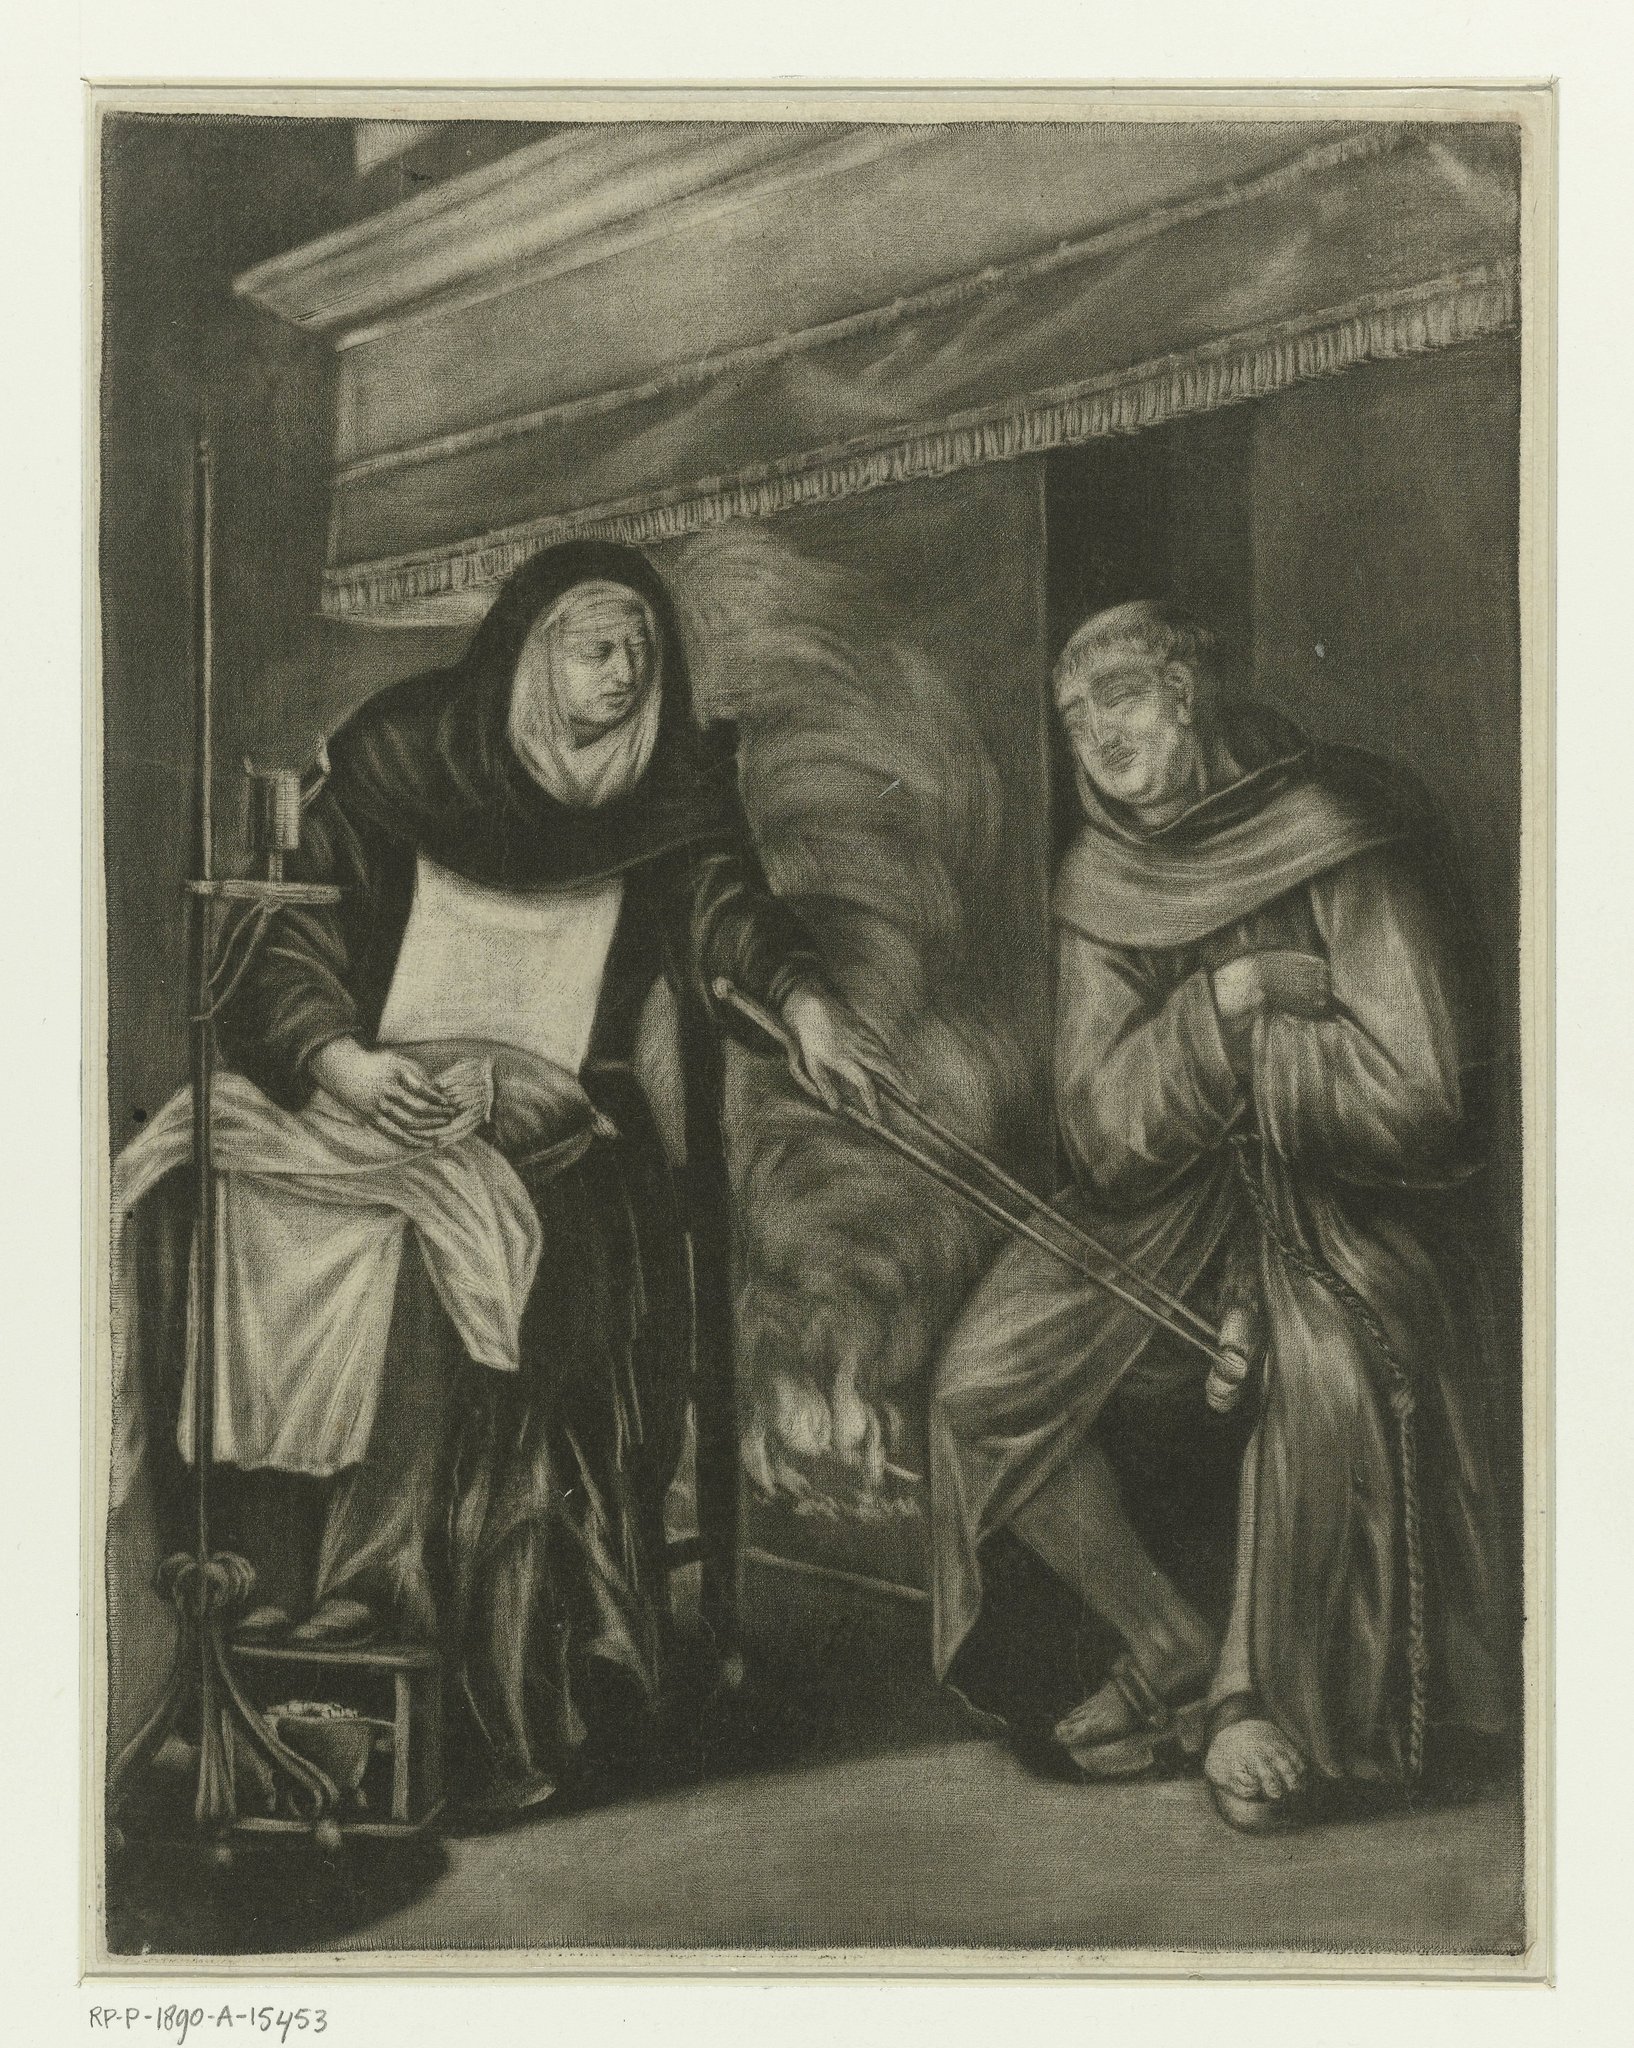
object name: print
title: Slapende monnik door een non met een haardtang gewekt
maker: jan van somer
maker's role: draughtsman, print maker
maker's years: 1645-1699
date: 1655-1699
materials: paper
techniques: mezzotint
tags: monk(s), friar(s)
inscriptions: collector's mark: Lugt 2228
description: Een non grijpt een slapende monnik bij zijn geslachtsdeel met een haardtang.